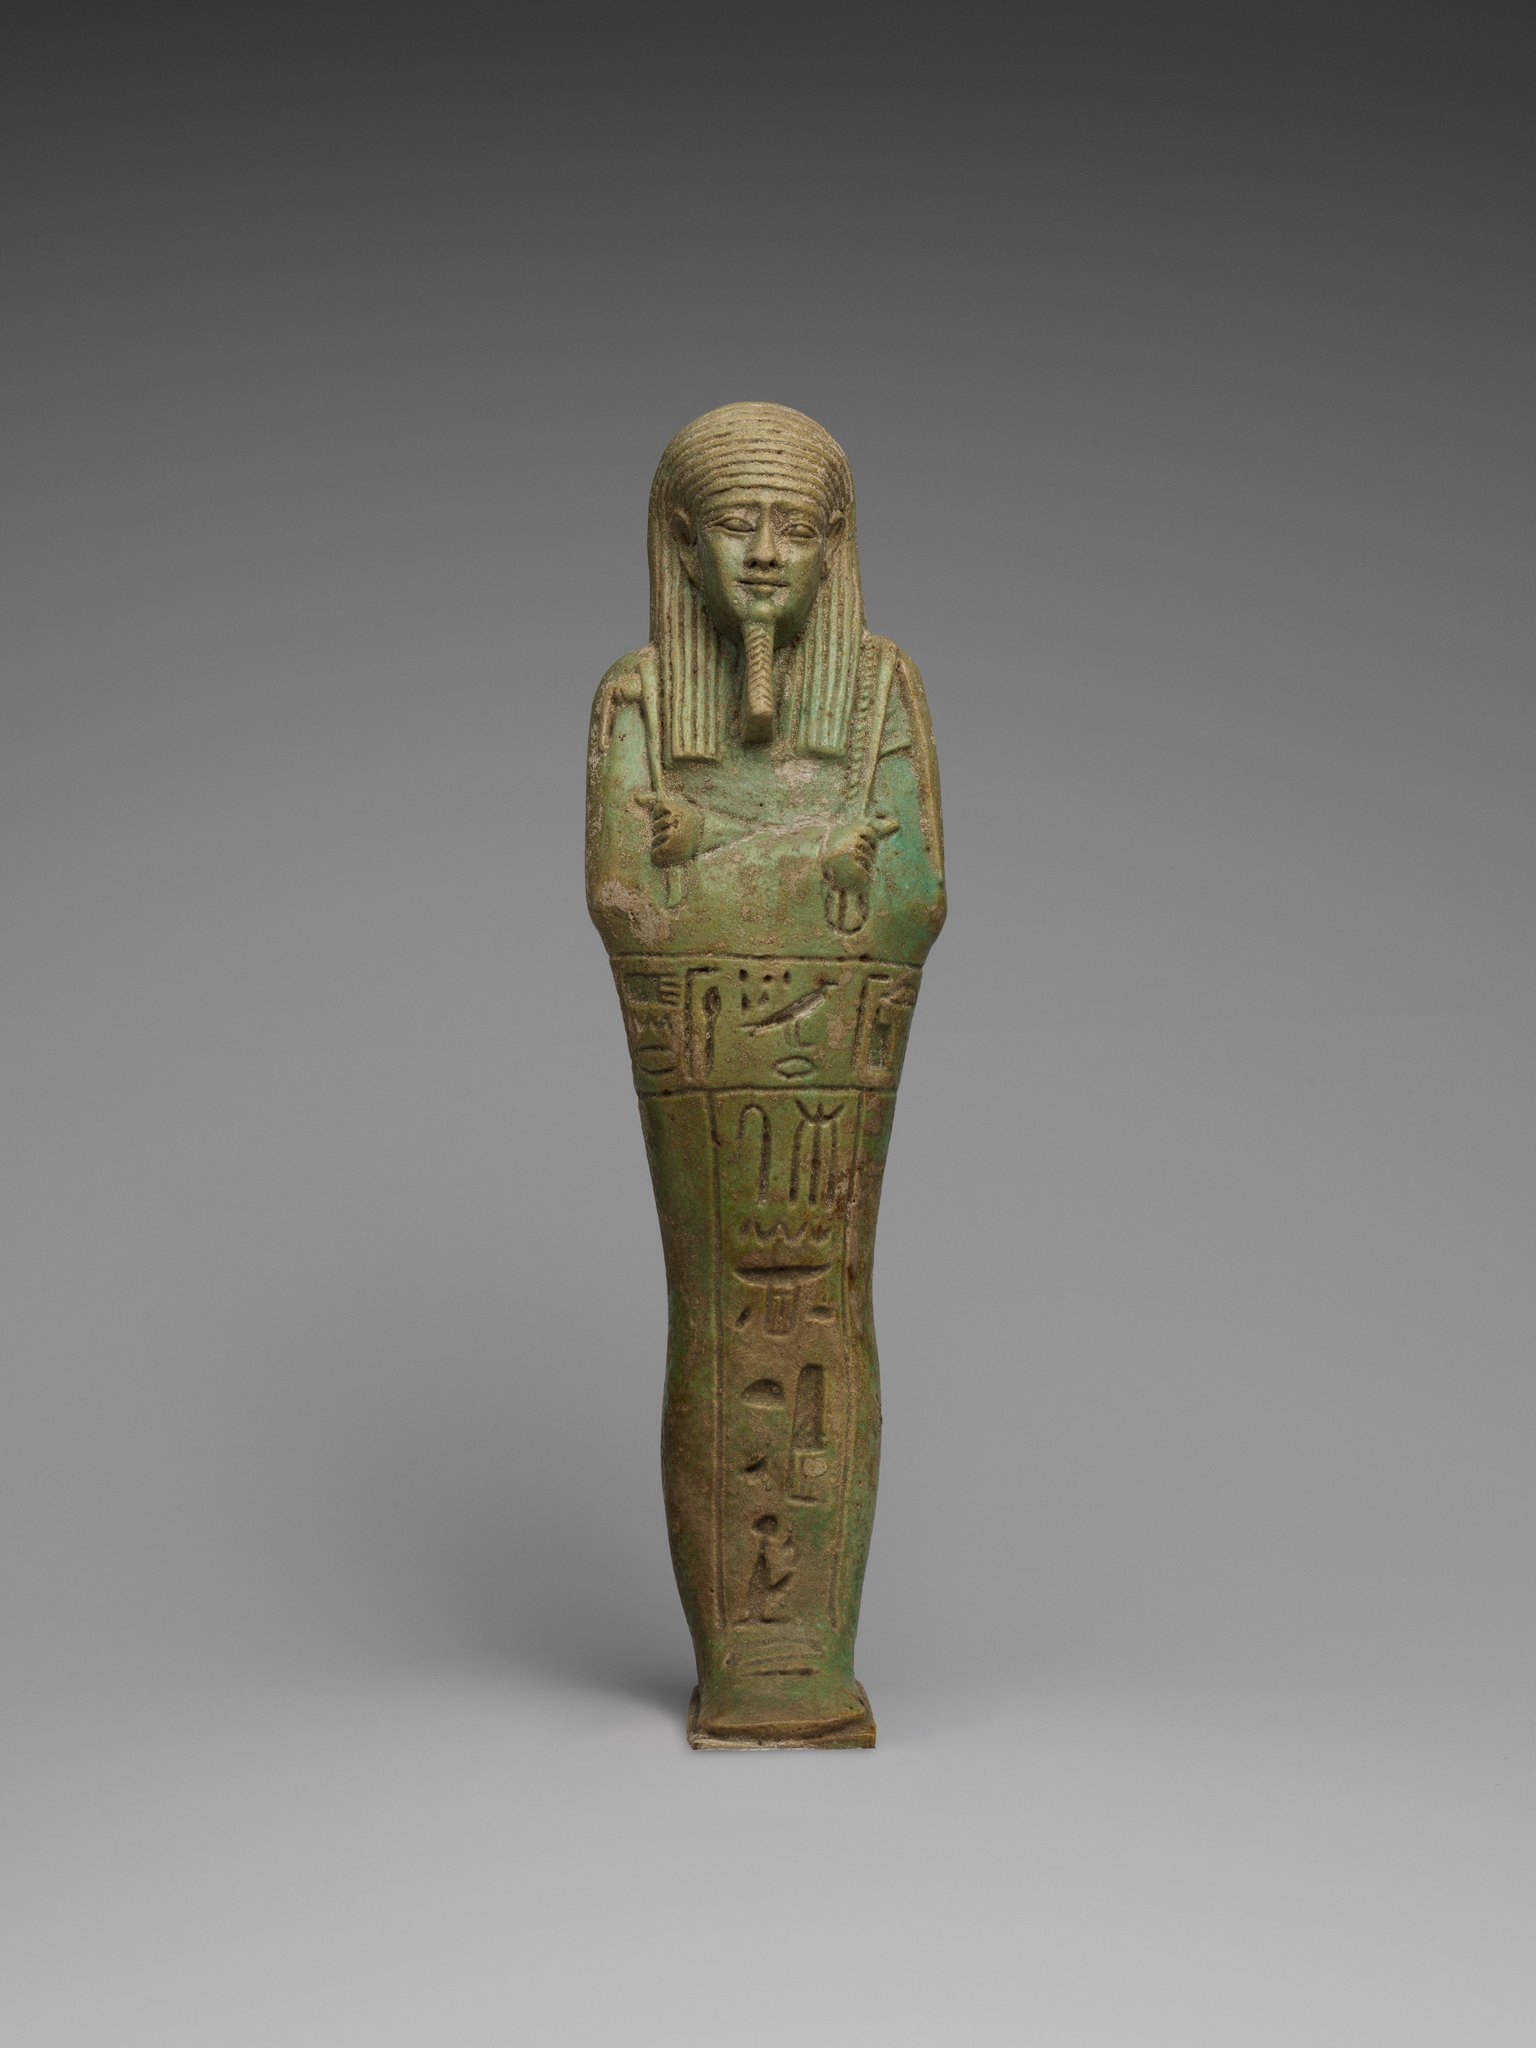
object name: shabti, priest djehutyirdis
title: Shabti of the High Priest of Thoth Djehutyirdis, born of Nephthysiti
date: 380-362 BCE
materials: faience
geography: middle egypt